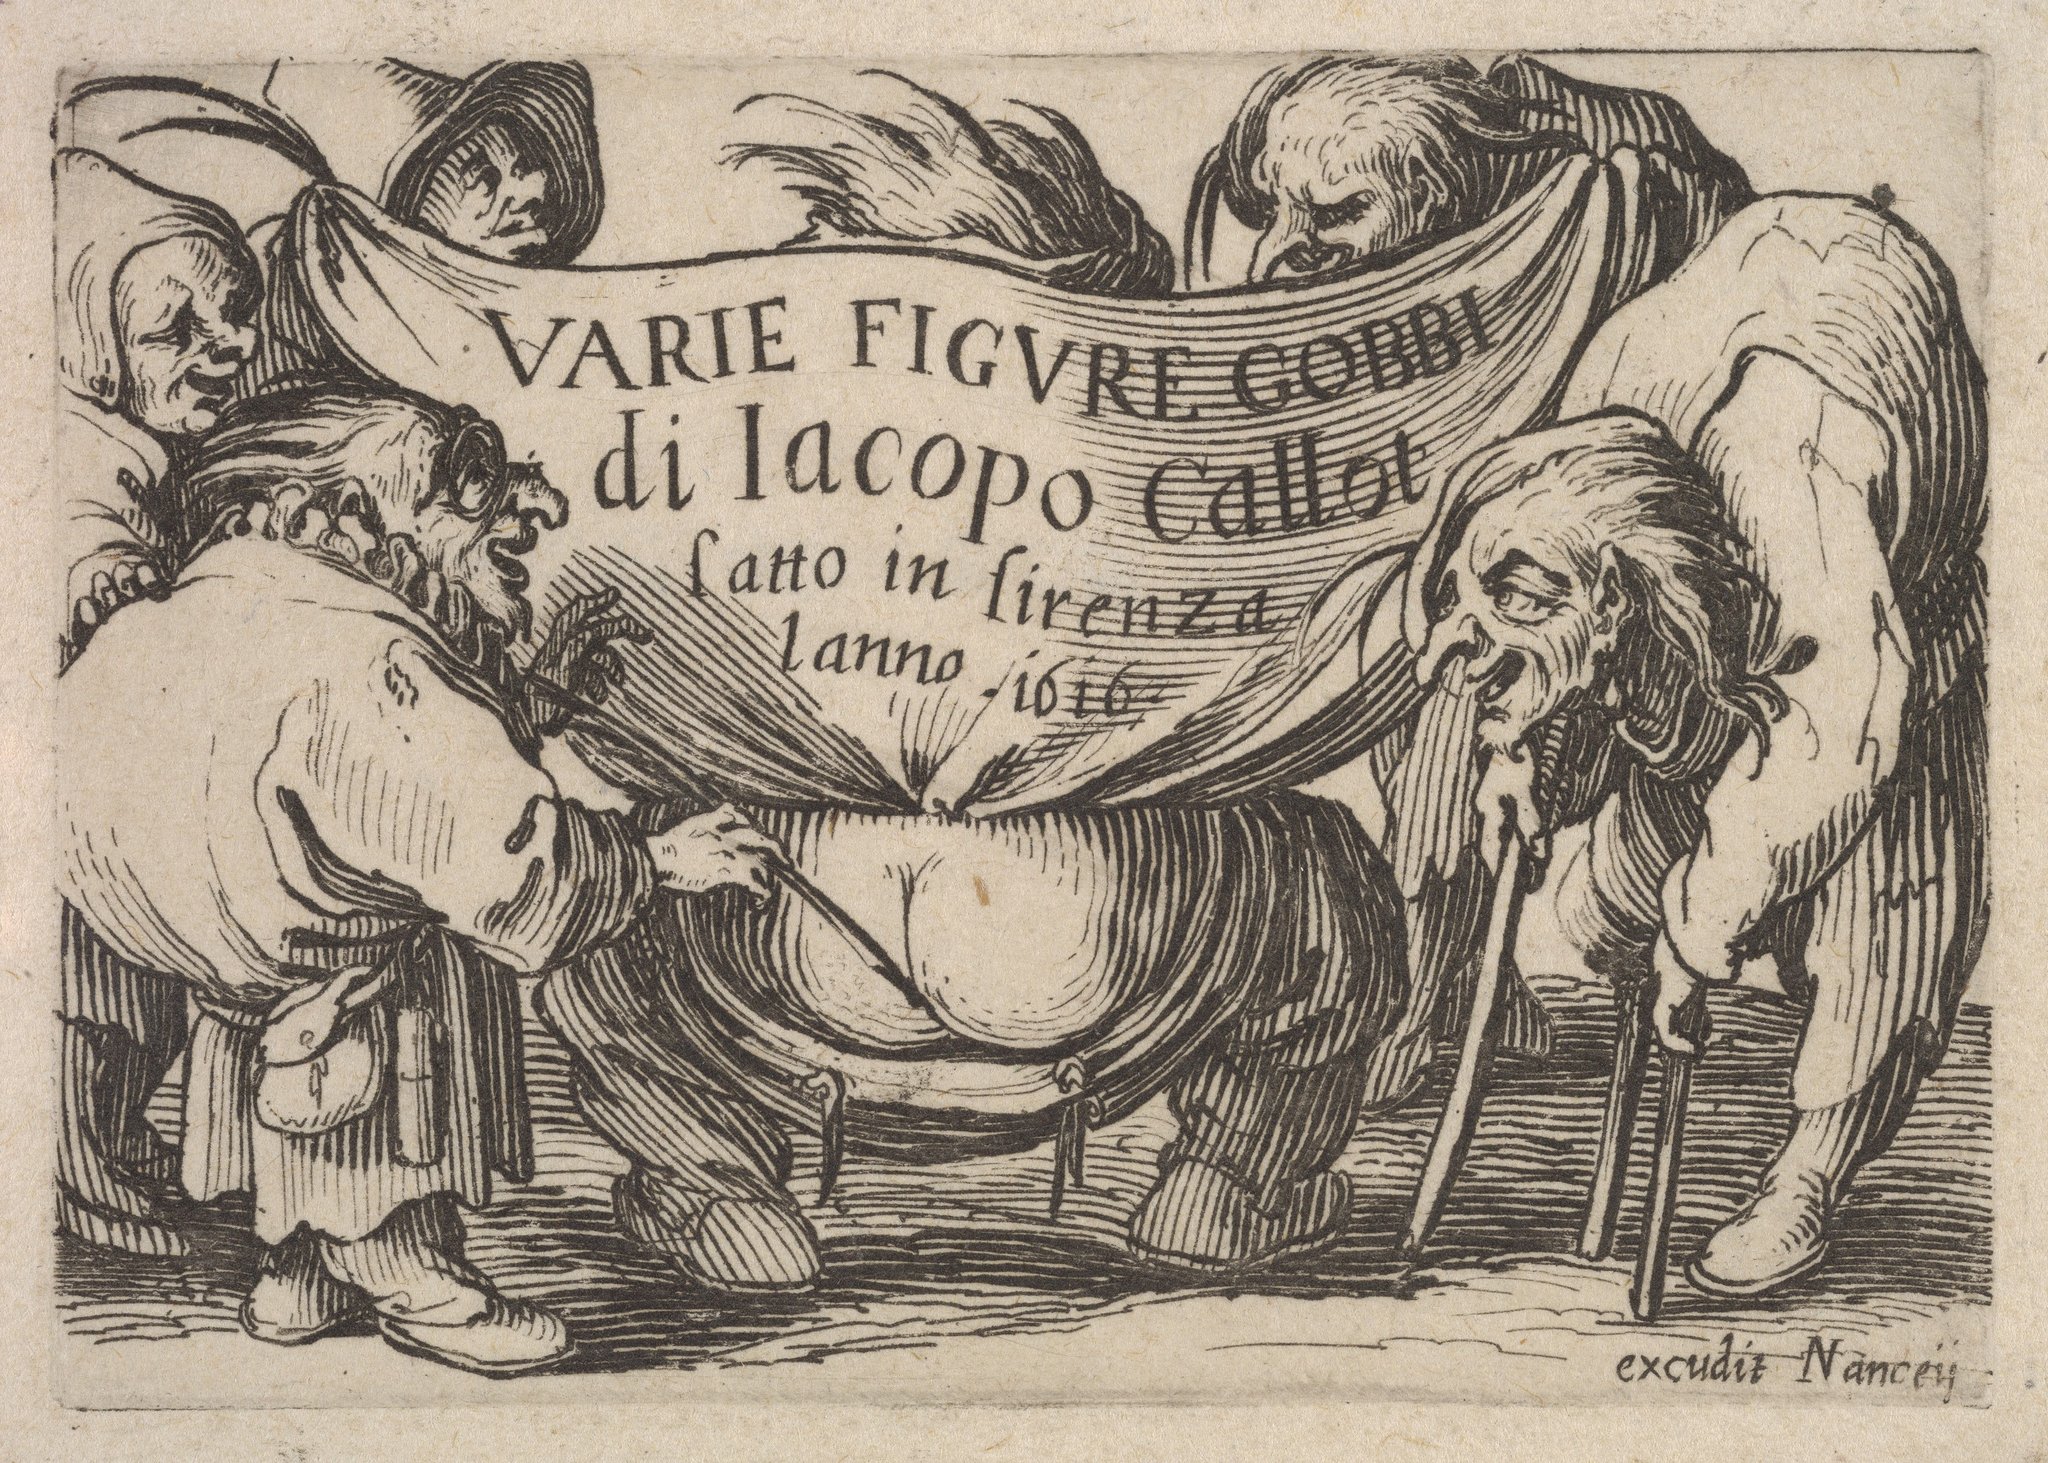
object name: print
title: Title page from "Varie Figure Gobbi"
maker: jacques callot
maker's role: artist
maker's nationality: french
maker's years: 1592-1635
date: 1621-1625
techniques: etching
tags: human figures,male nudes